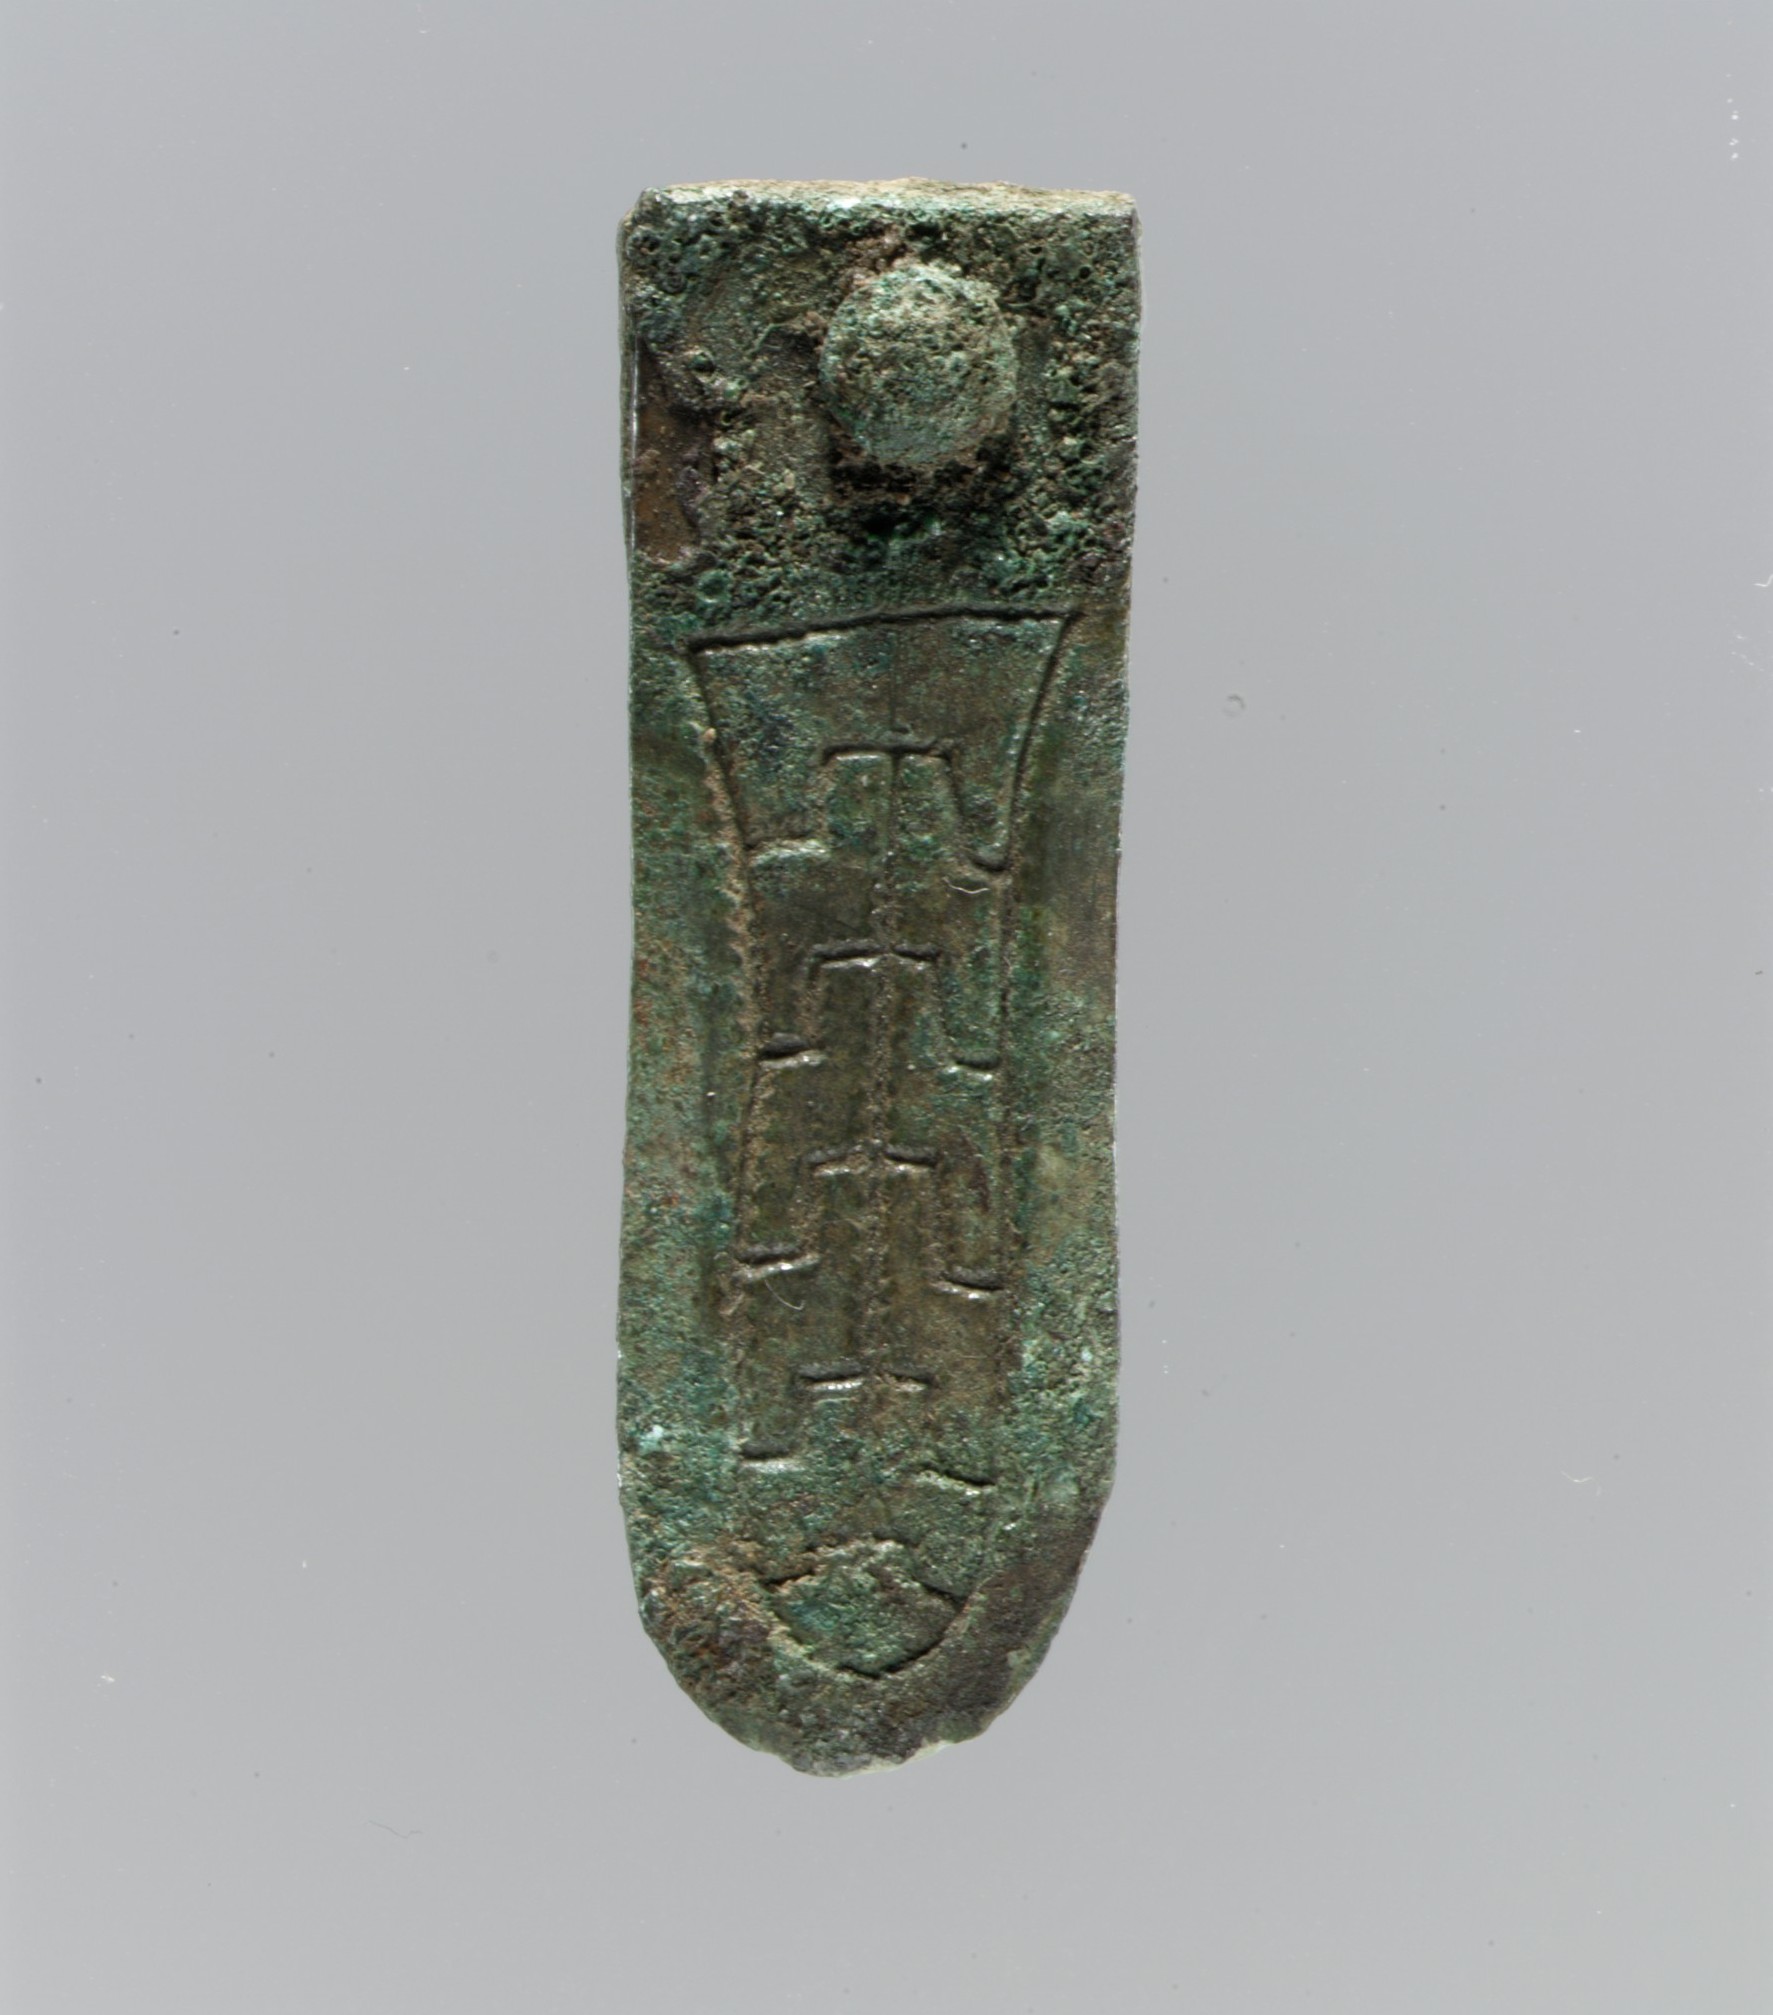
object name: ferret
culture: frankish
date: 501-700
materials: copper alloy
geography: germany